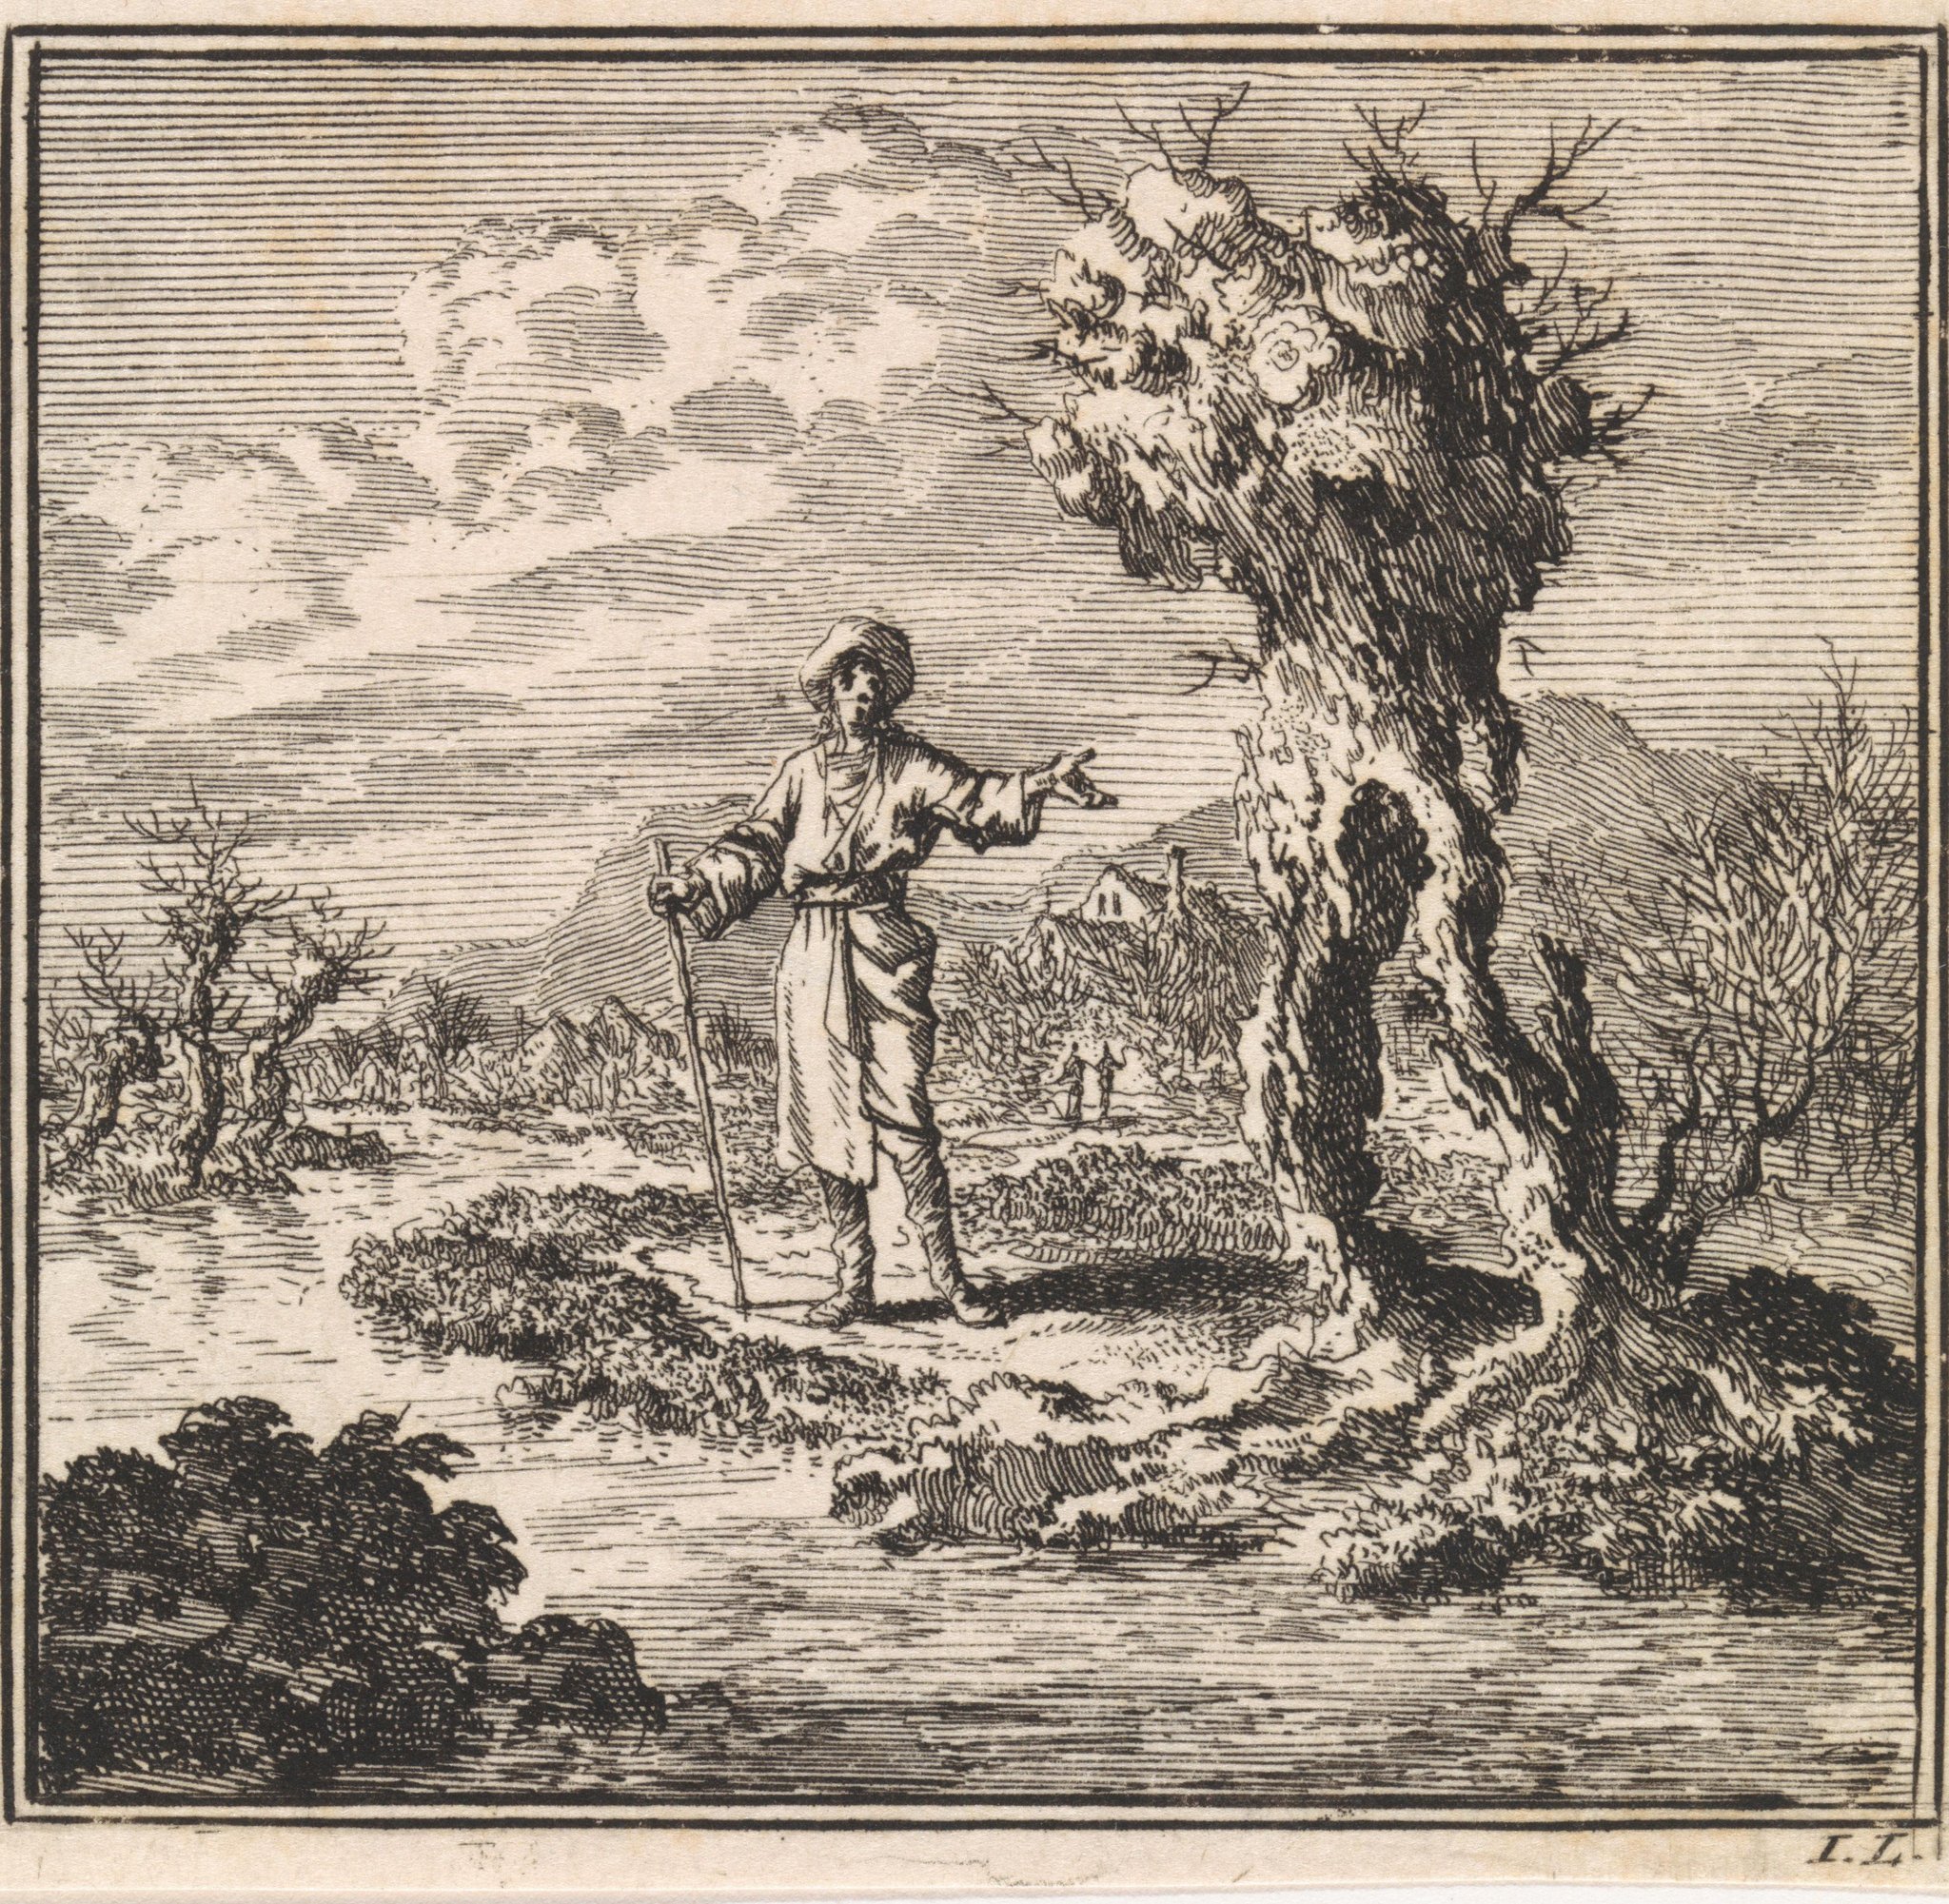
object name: print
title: Aan de waterkant wijst een man op een knotwilg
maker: jan luyken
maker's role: draughtsman, print maker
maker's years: 1649-1712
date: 1711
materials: paper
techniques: etching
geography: amsterdam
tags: landscapes, river, trees: willow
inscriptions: collector's mark: Lugt 2228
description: Illustratie voor: Luyken, Jan. De Bykorf des Gemoeds. Amsterdam: Pieter Arentsz. II (wed.) en Cornelis van der Sys, 1711m, p. 22.